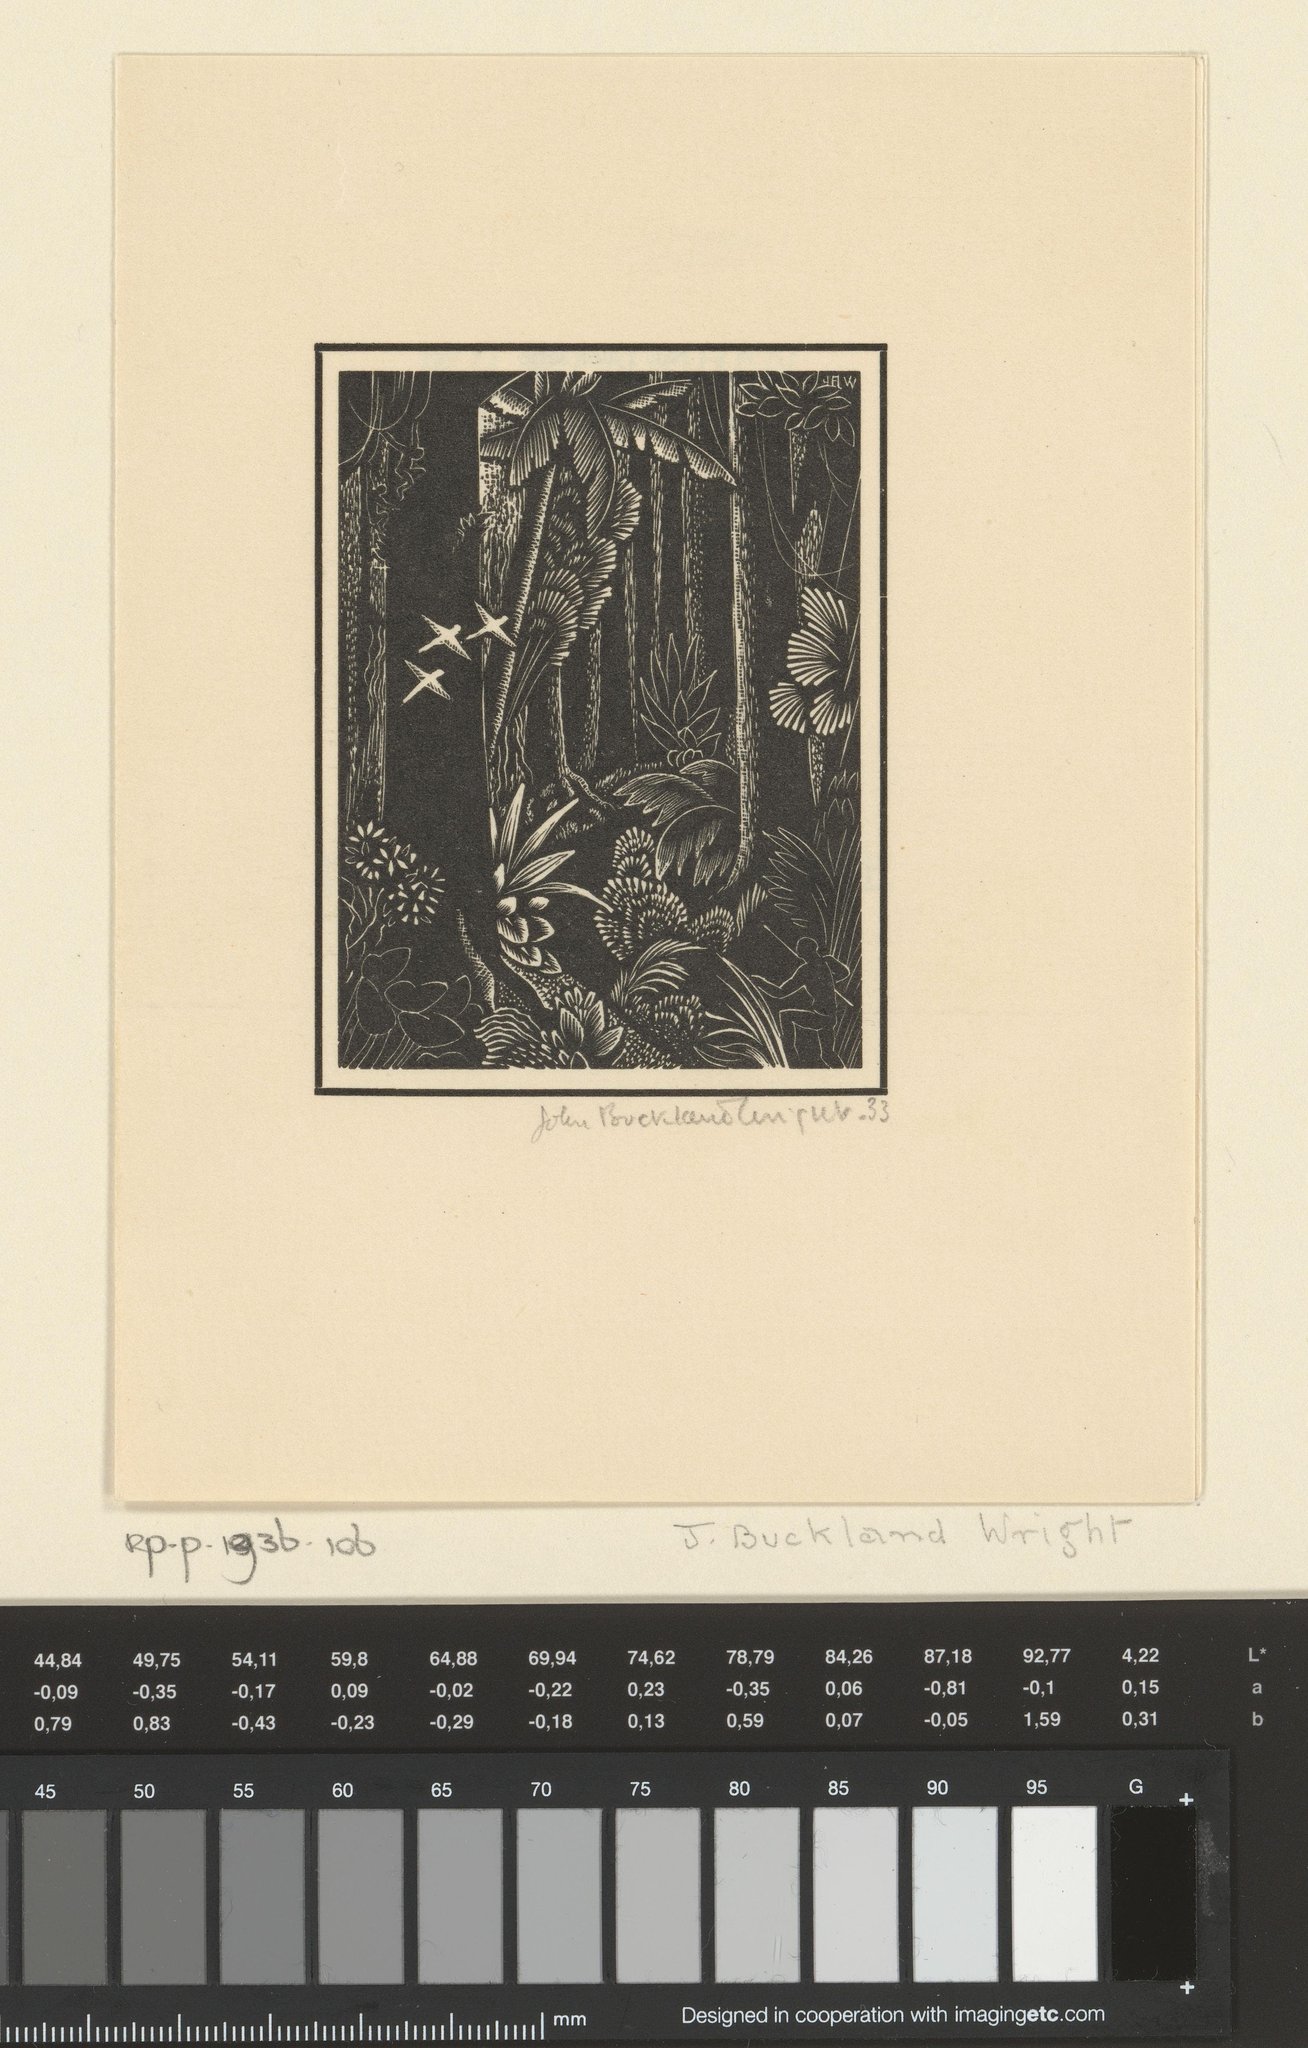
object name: print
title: Nieuwjaarswens voor 1934 van N.V. Houtindustrie Picus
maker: john buckland wright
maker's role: print maker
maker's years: 1897-1954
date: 1933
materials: paper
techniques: engraving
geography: eindhoven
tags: hunters hunting (n.b.: in 1988-1990 this notation denoted the concept of 43c11421 'hunters resting during the hunt'), jungle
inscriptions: collector's mark: Lugt 2228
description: Deze prent is ook uitgegeven als onderdeel van de serie 'Negen houtsneden', waarin het productieproces van het hout van N.V. Houtindustrie Picus wordt verbeeld. In die serie is dit de eerste prent.